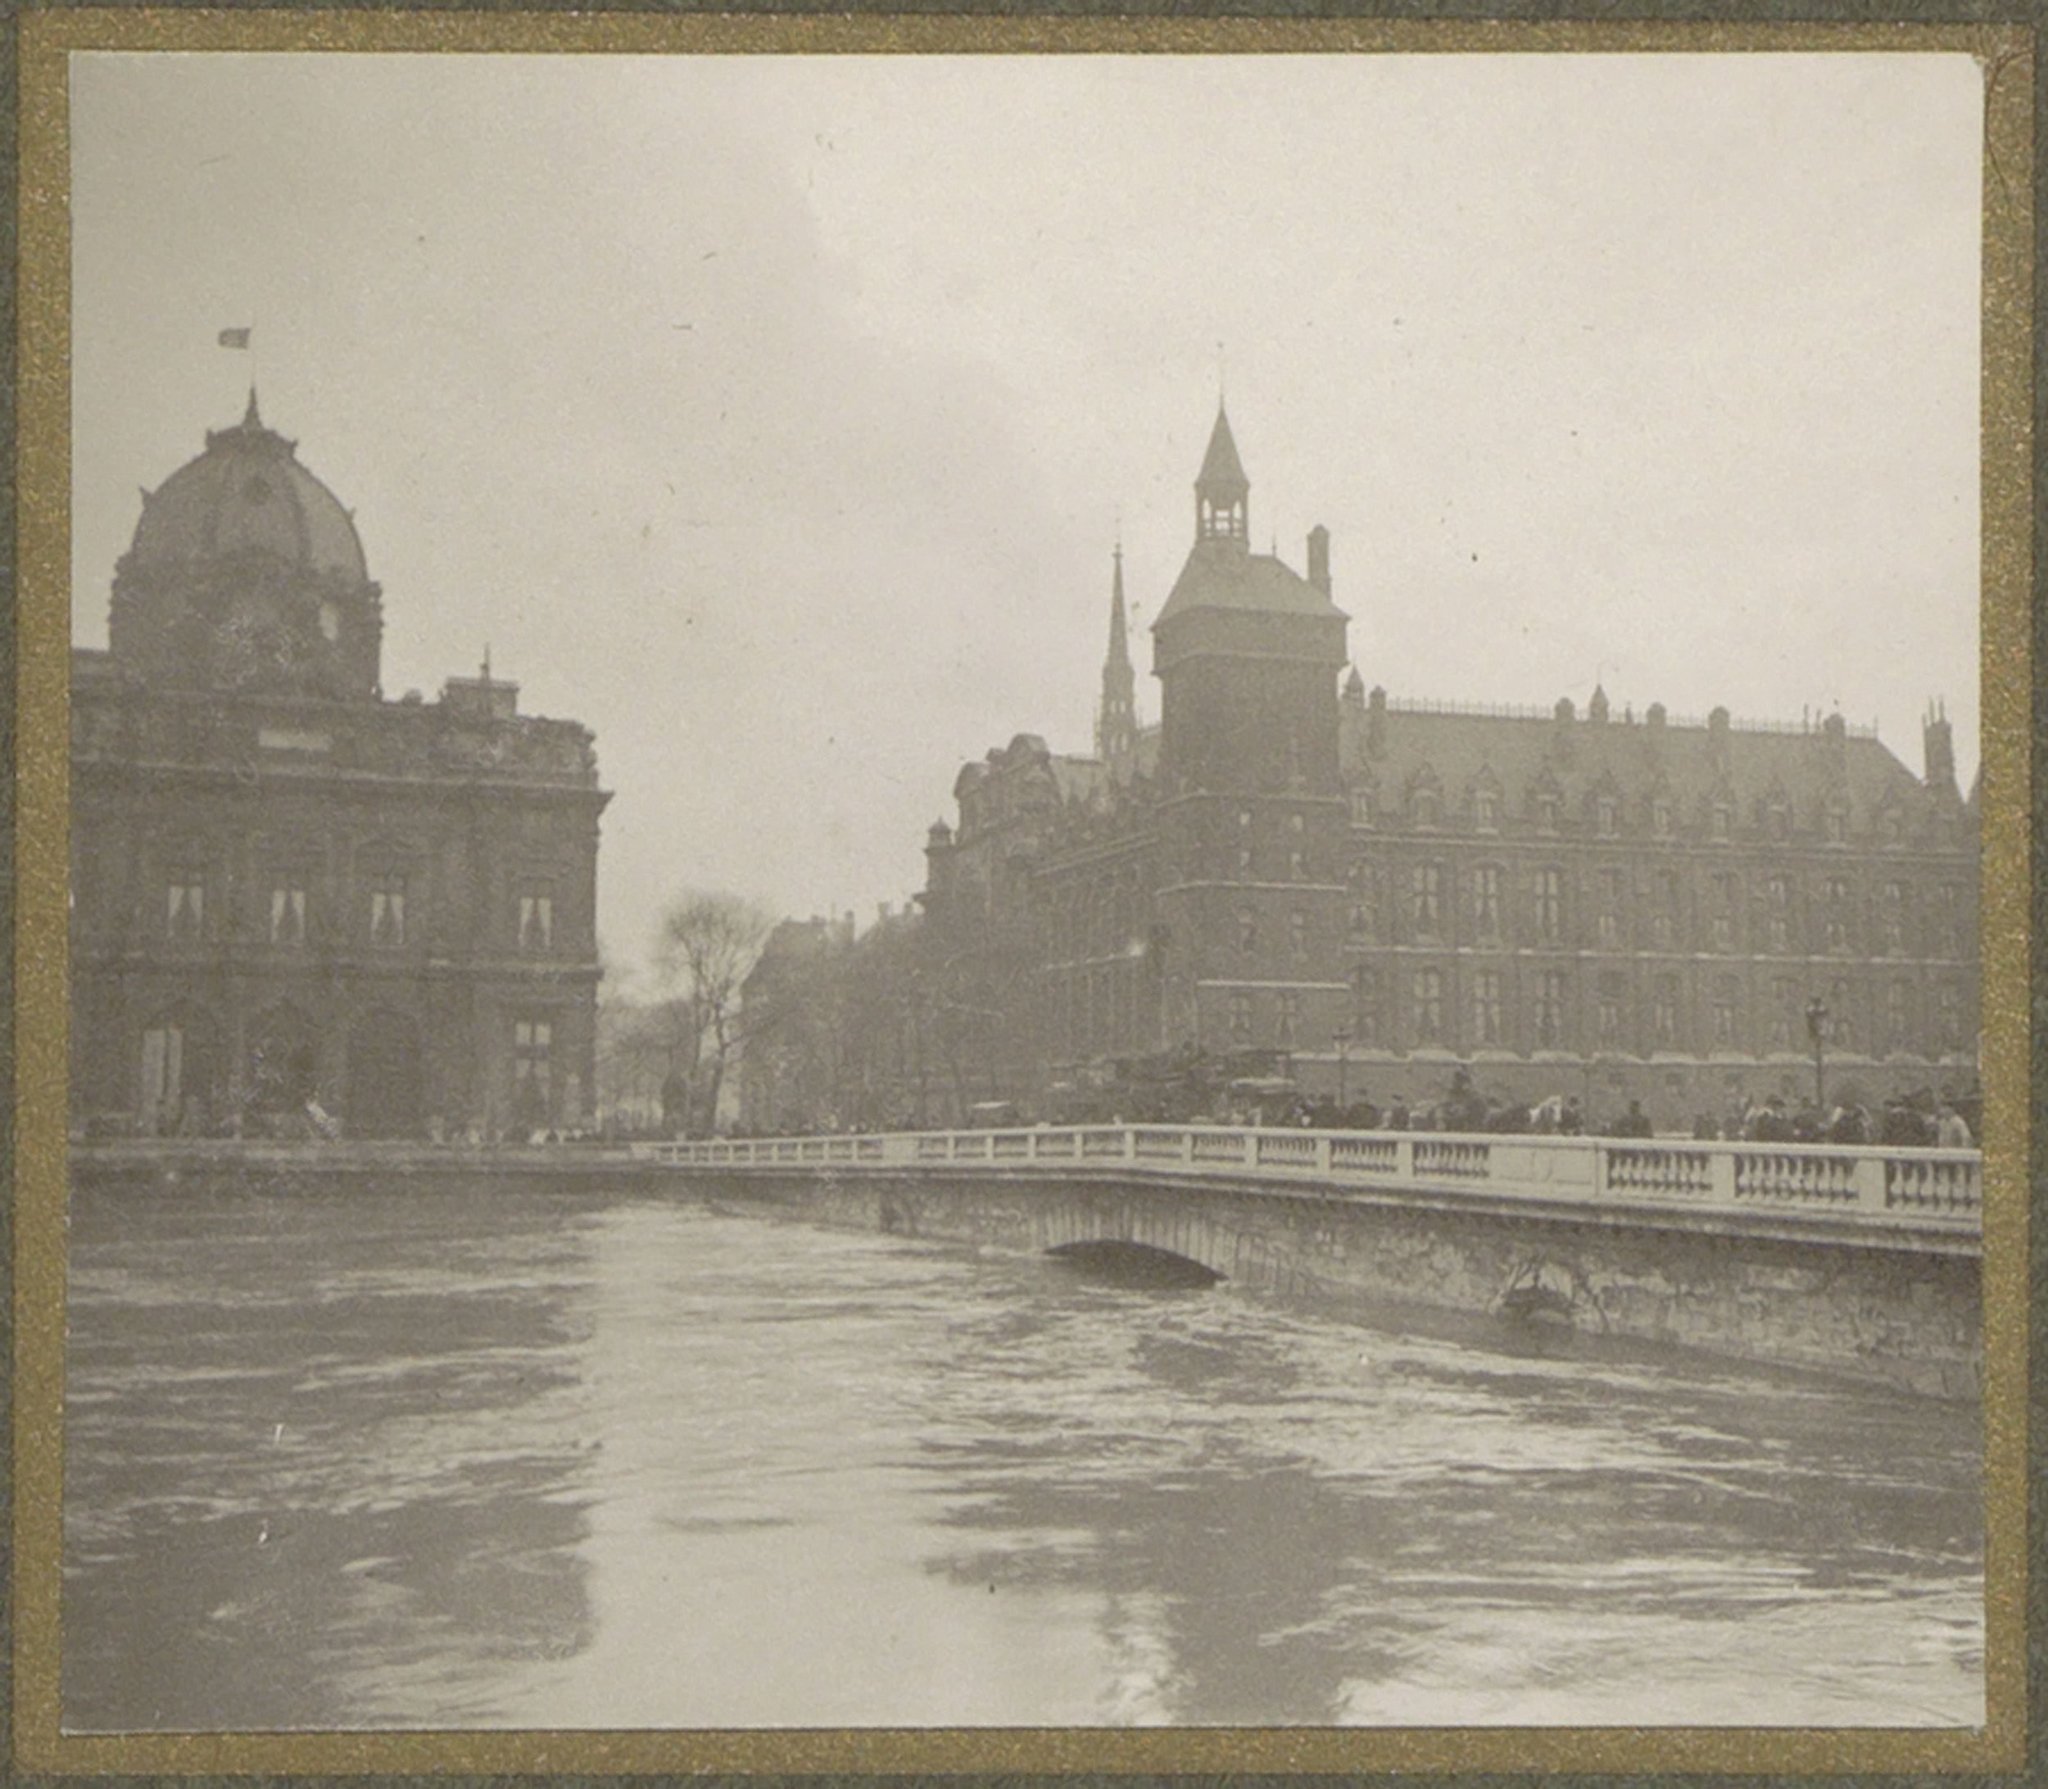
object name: photograph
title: Zeer hoge waterstand in de Seine , op de achtergrond gebouwen op het Île de la Cité van Parijs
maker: g. dangereux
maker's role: fotograaf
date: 1901-1910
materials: photographic support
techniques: matte daylight collodion silver print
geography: paris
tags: flood (+ landscape with figures, staffage), tower, clock tower ~ monumental adornment, bridge, dome ~ architecture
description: Rechts de Pont au Change, de boog nagenoeg onzichtbaar door de hoge waterstand. Op de achtergrond rechts La Conciergerie aan de Quai de l'Horloge, links het Tribunal de commerce de Paris aan de Quai de la Corse. Onderdeel van Fotoalbum overstroming Parijs en voorsteden 1910.